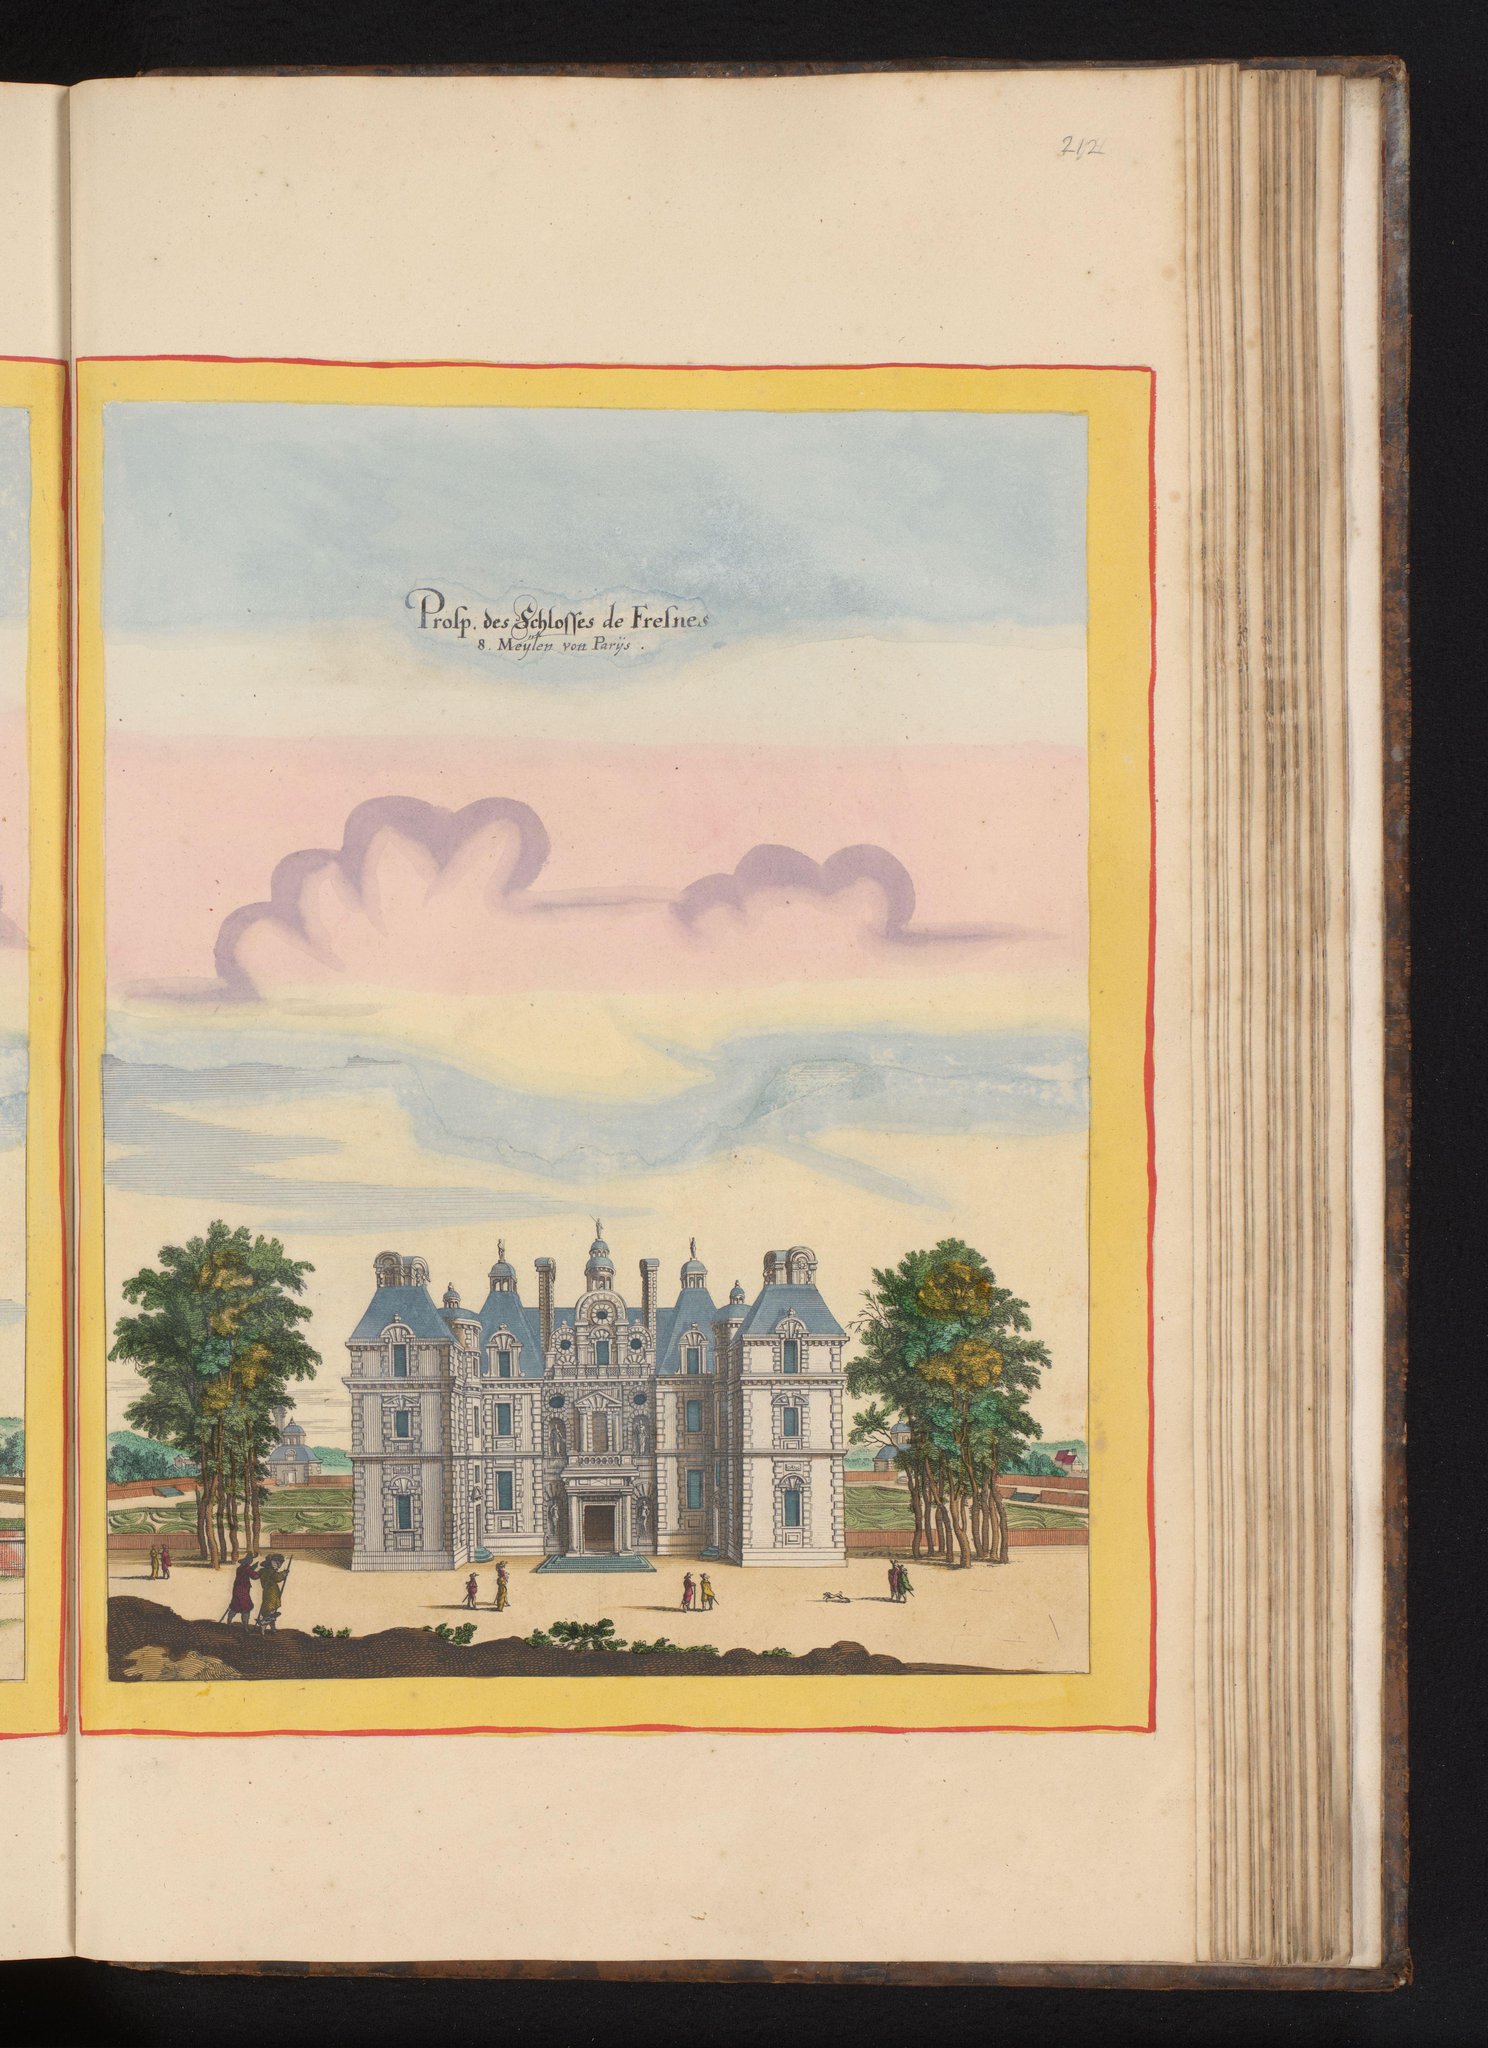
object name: album leaf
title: Gezicht op de ingang van Château de Berny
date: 1655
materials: paper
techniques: engraving, etching, hand coloring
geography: paris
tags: castle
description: Prent origineel vervaardigd als boekillustratie voor: Zeiller, Martin. Topographia Galliae, oder Beschreibung und Contrafaitung der vornehmbsten und bekantisten Oerter in dem mächtigen und grossen Königreich Frankreich, 13 delen. Frankfurt am Main: Caspar Merian, 1655-1661. De prent werd voor het eerst gepubliceerd in deel 1: Topographia Galliae, 1655. De prent is langs de bovenrand van de voorstelling afgescheurd. De titel is hoger opgeplakt. De voorstelling is aan de bovenzijde aangevuld met een geschilderde lucht.